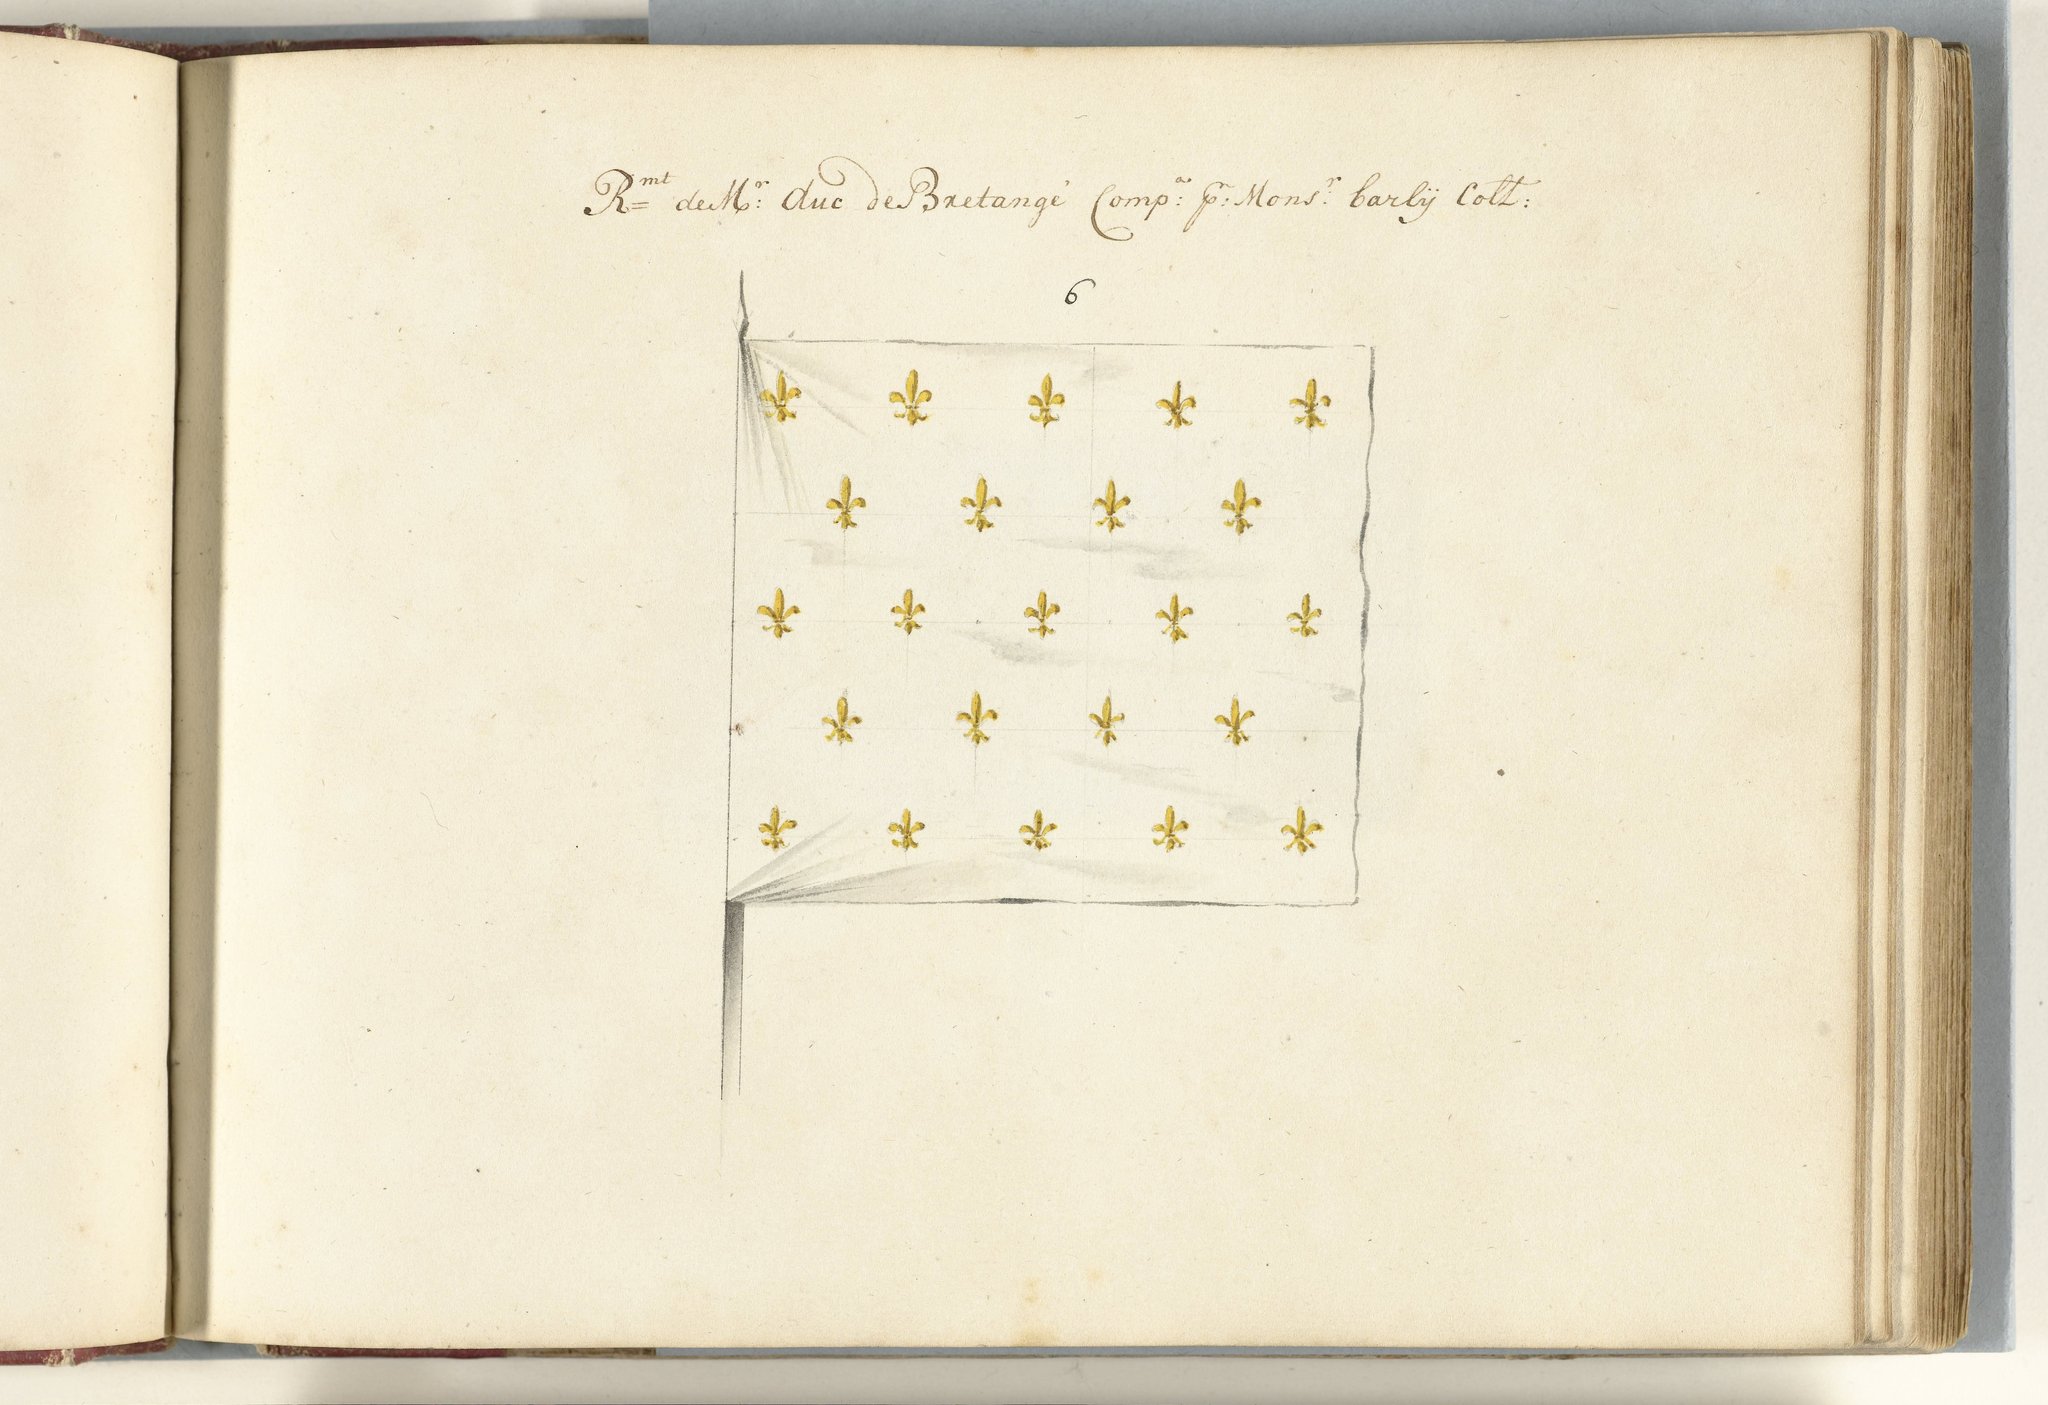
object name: drawing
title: Rmt. de Mr. Duc de Bretagne Compa. G. Monsr. barly Colt.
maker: Anonymous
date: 1713-1720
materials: paper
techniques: drawing, writing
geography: northern netherlands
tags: (military) flags and standards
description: Frans vaandel veroverd bij de slag bij Ramillies 1706. In het boek met tekeningen van Franse vaandels, standaarden en pauken, veroverd tijdens de Spaanse Successieoorlog (1701-1713).